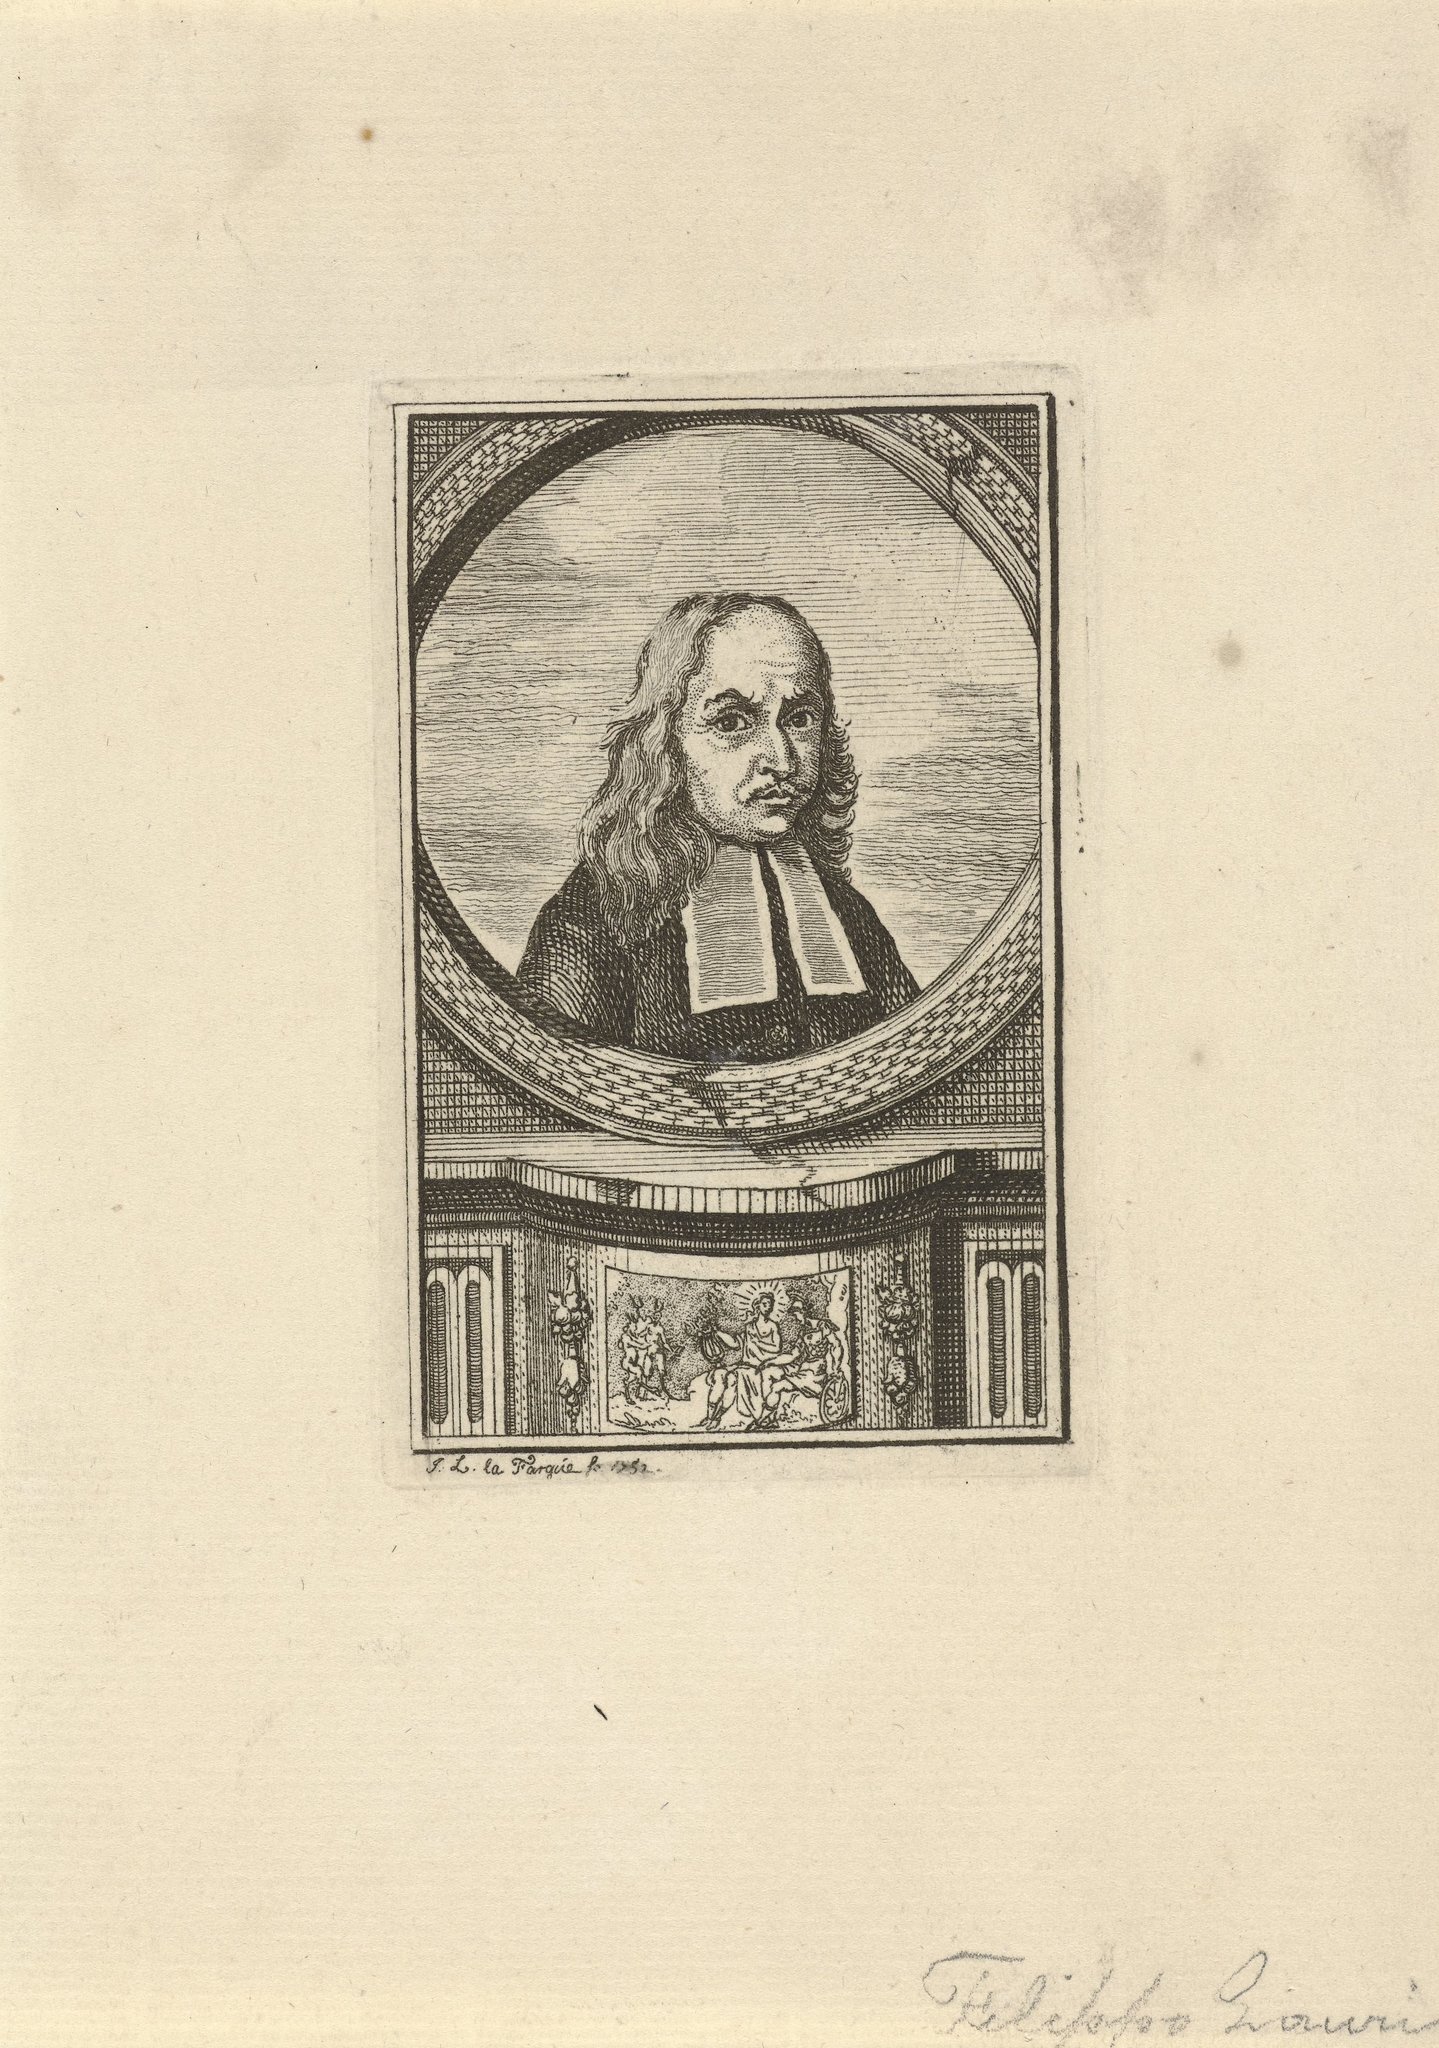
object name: print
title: Portretten van Italiaanse kunstenaars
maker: isaac lodewijk la fargue van nieuwland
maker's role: draughtsman, painter, print maker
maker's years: 1726-1805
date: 1752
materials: paper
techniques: etching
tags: rome, painter, draughtsman, filippo lauri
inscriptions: collector's mark: Lugt 2228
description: Prent opgenomen in: Dézallier d'Argenville, Antoine Joseph. Tooneel der uitmuntende schilders van Europa, en byzonderlyk van Nederland. Den Haag: Mattheus Gaillard, 1752.